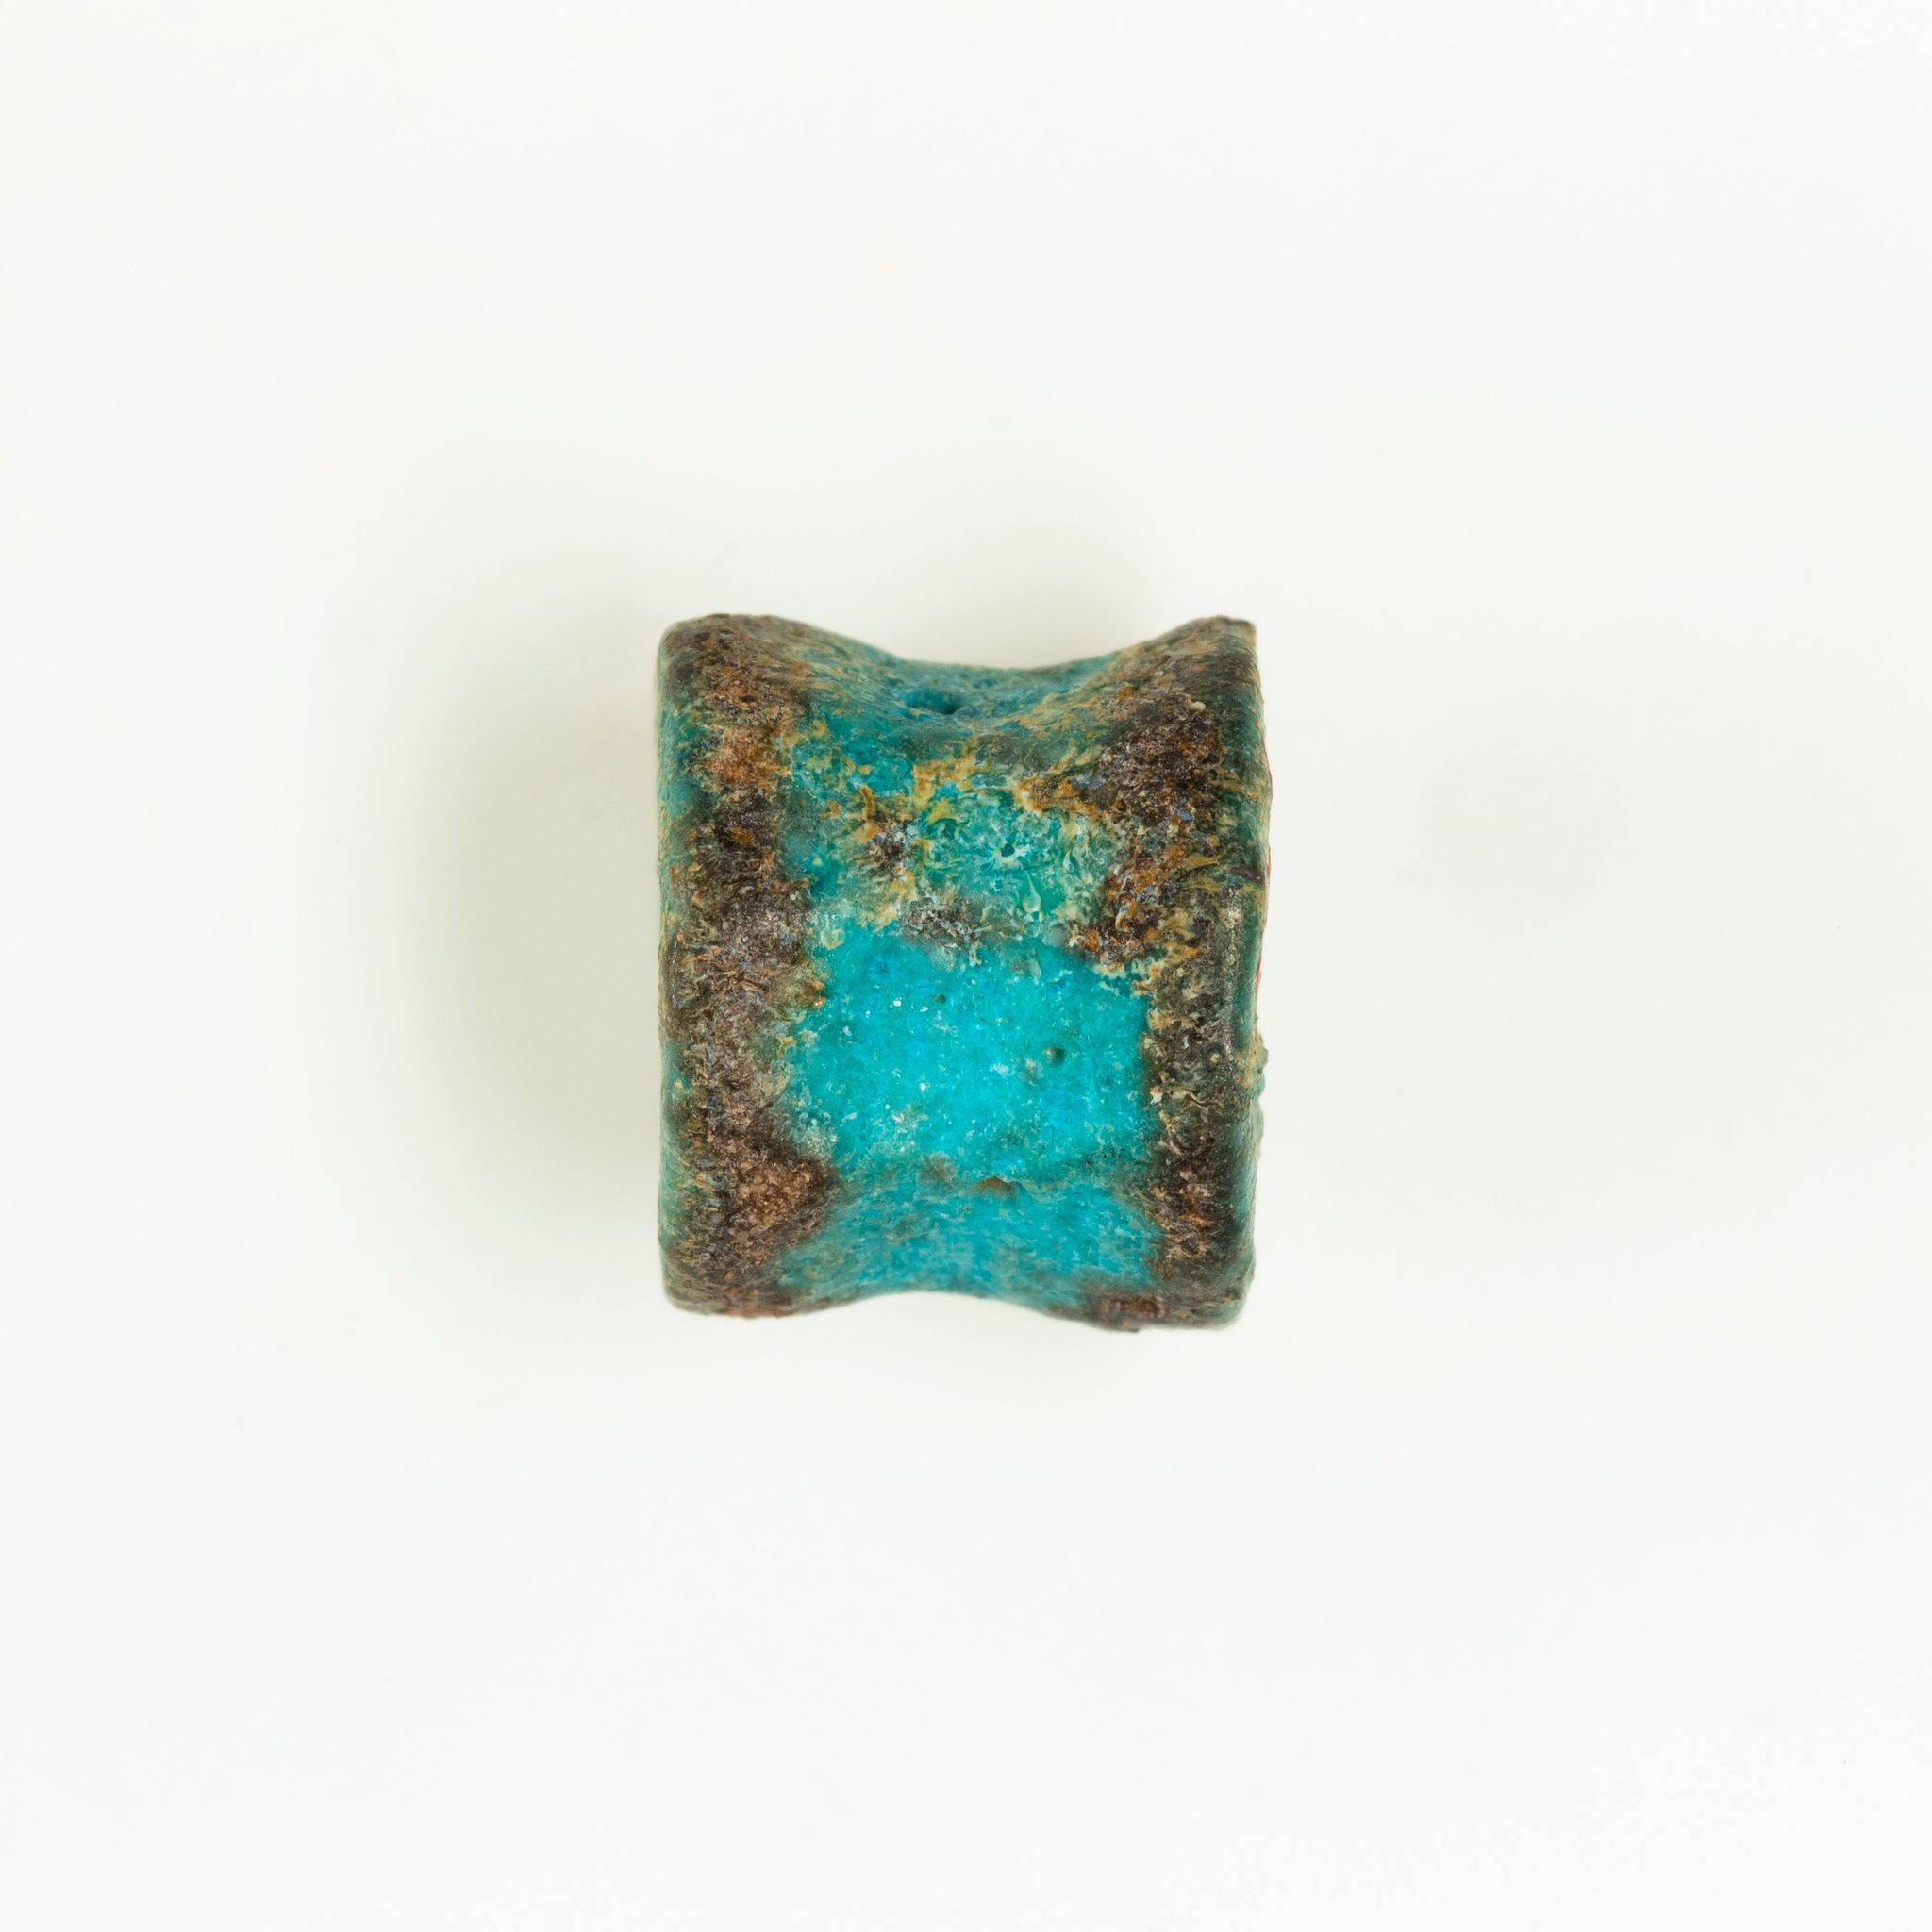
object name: bead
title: Spool-shaped bead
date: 1850-1640 BCE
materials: faience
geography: egypt